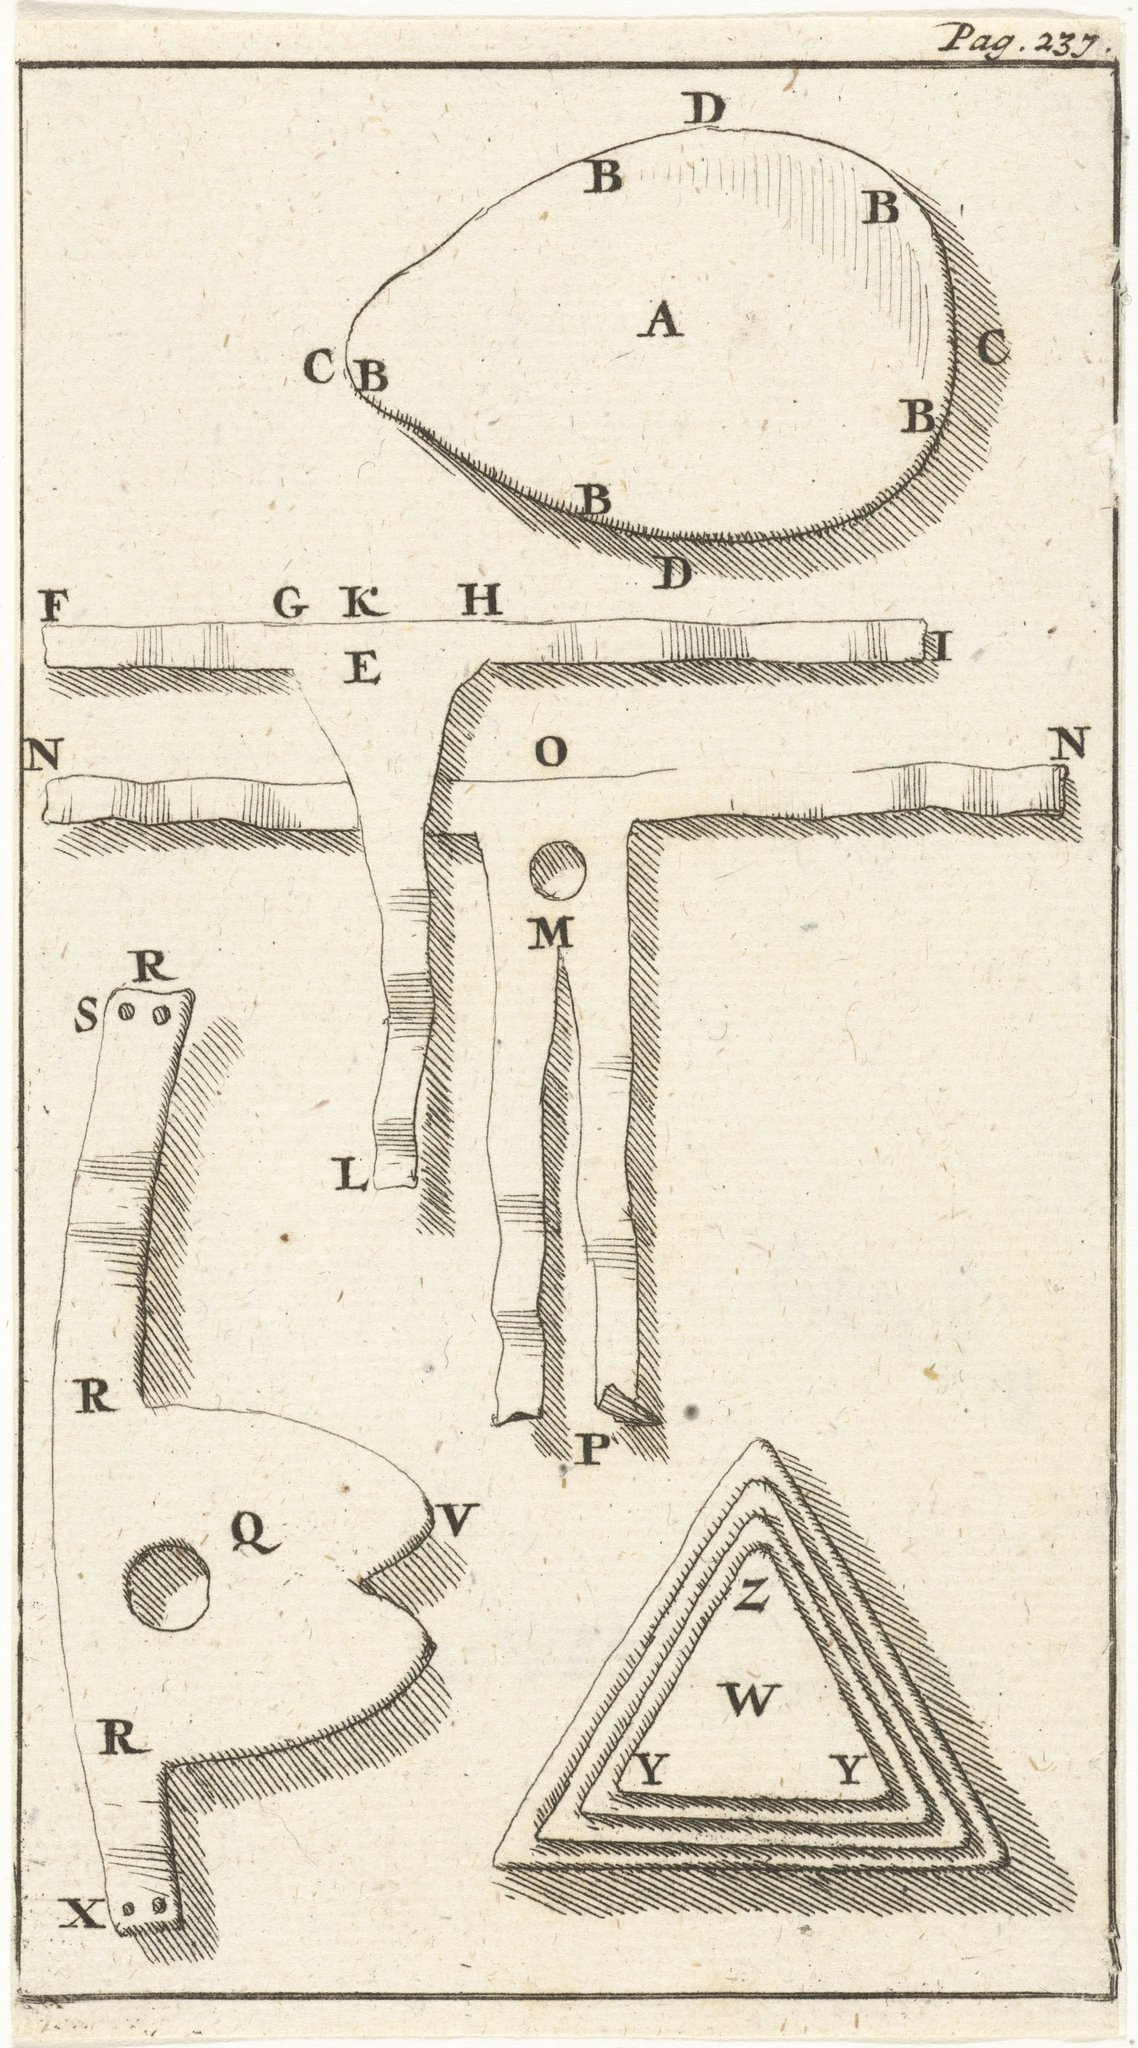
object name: book illustration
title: Weergave van verschillende verbanden A-Z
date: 1691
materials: paper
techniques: etching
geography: amsterdam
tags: dressing, bandage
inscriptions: collector's mark: Lugt 2228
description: Illustratie uit: Verduc, Laurent. Het Parische verband-huis, waarin getoont werd, de wyse om alle fracturen en luxatien (...) te genesen. Amsterdam: Jan Claesz ten Hoorn, 1691.